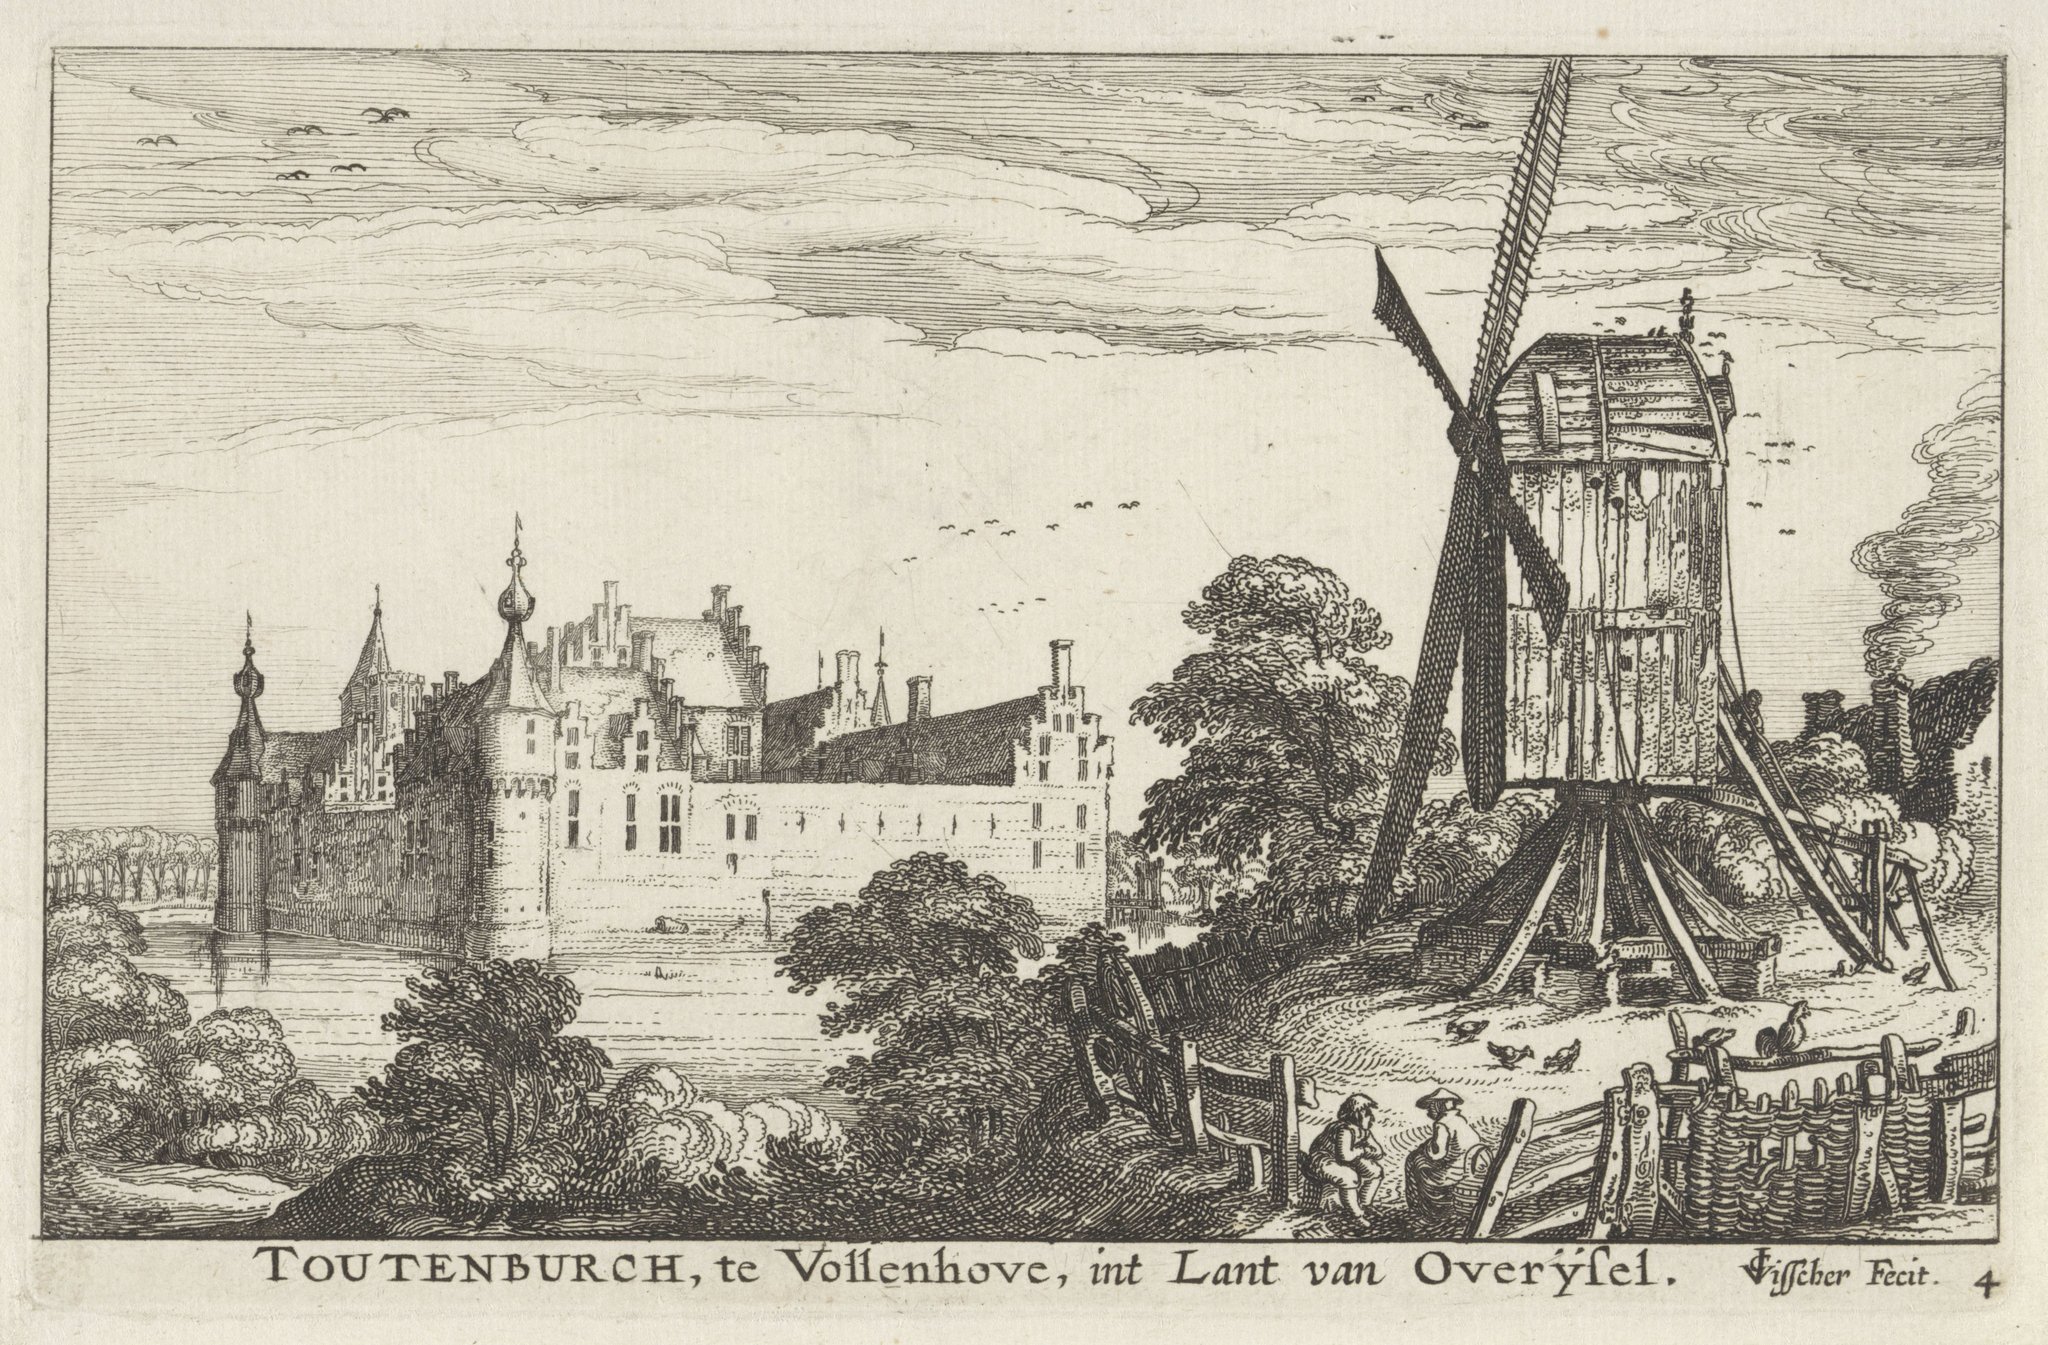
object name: print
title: Kasteel Toutenburg in Vollenhove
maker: claes jansz. visscher (ii)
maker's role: draughtsman, print maker, publisher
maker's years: 1586-1652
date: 1617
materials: paper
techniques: etching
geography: amsterdam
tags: castle, windmill in landscape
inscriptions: collector's mark: Lugt 2228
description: Landschap met kasteel Toutenburg te Vollenhove. Rechts op de voorgrond een molen. Vierde prent in een serie van vier met kastelen in Holland en Utrecht.